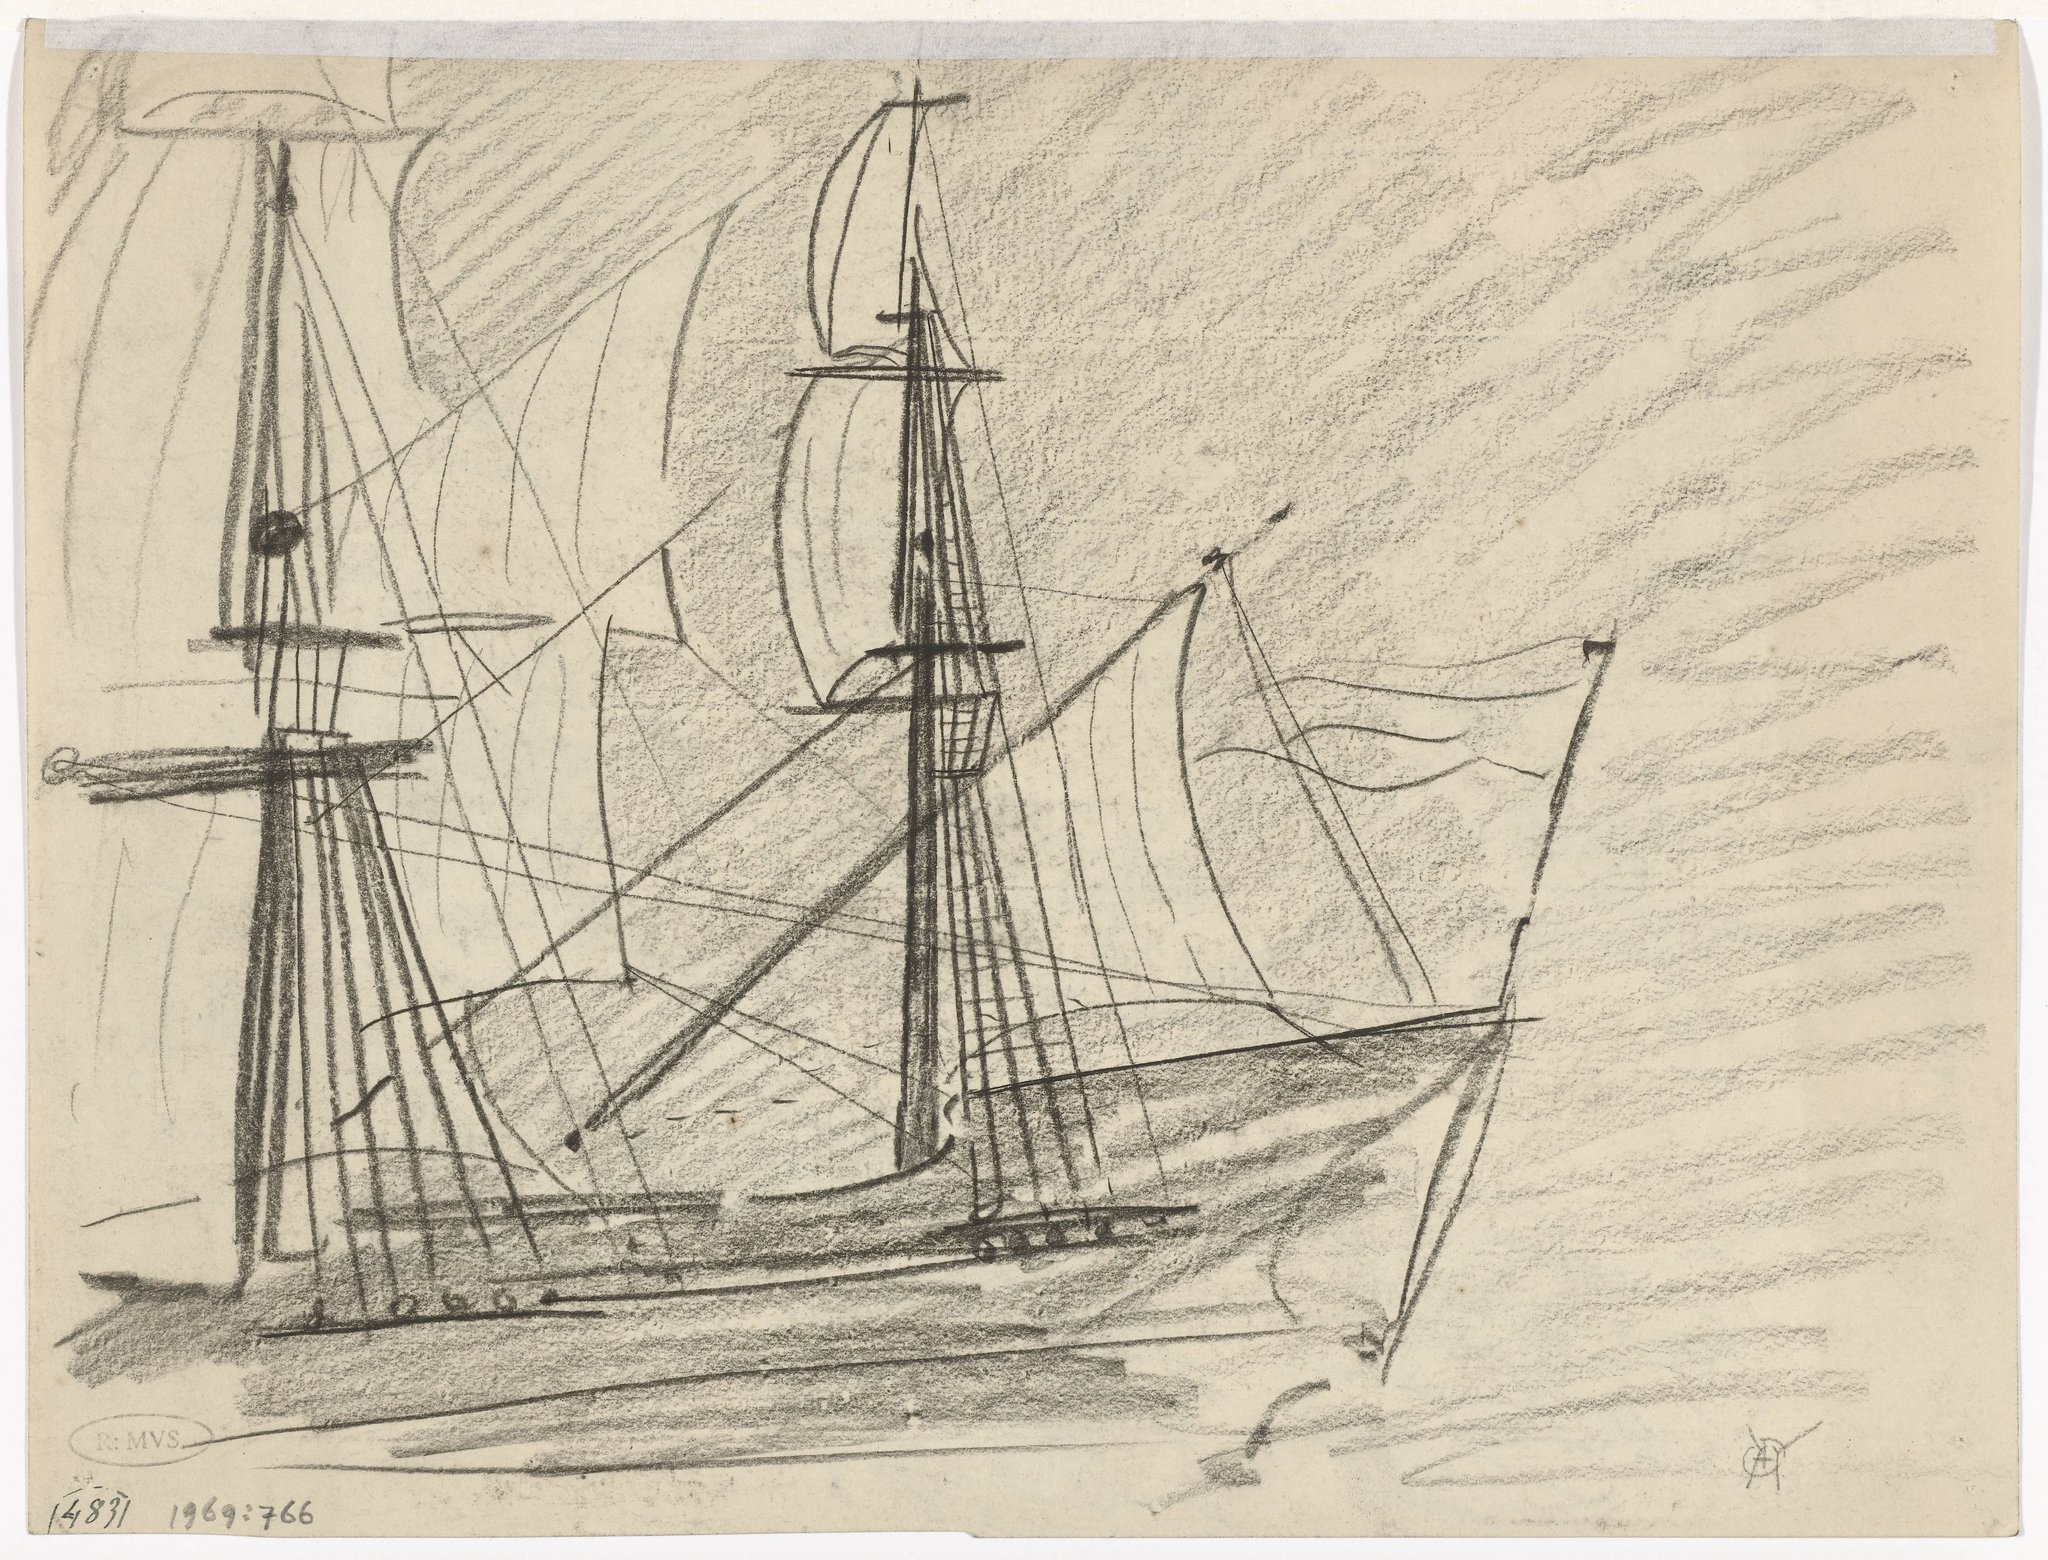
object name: drawing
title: Zeilschip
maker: gerrit willem dijsselhof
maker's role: designer, draughtsman, print maker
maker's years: 1866-1924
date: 1876-1924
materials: chalk, paper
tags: sailing-ship, sailing-boat